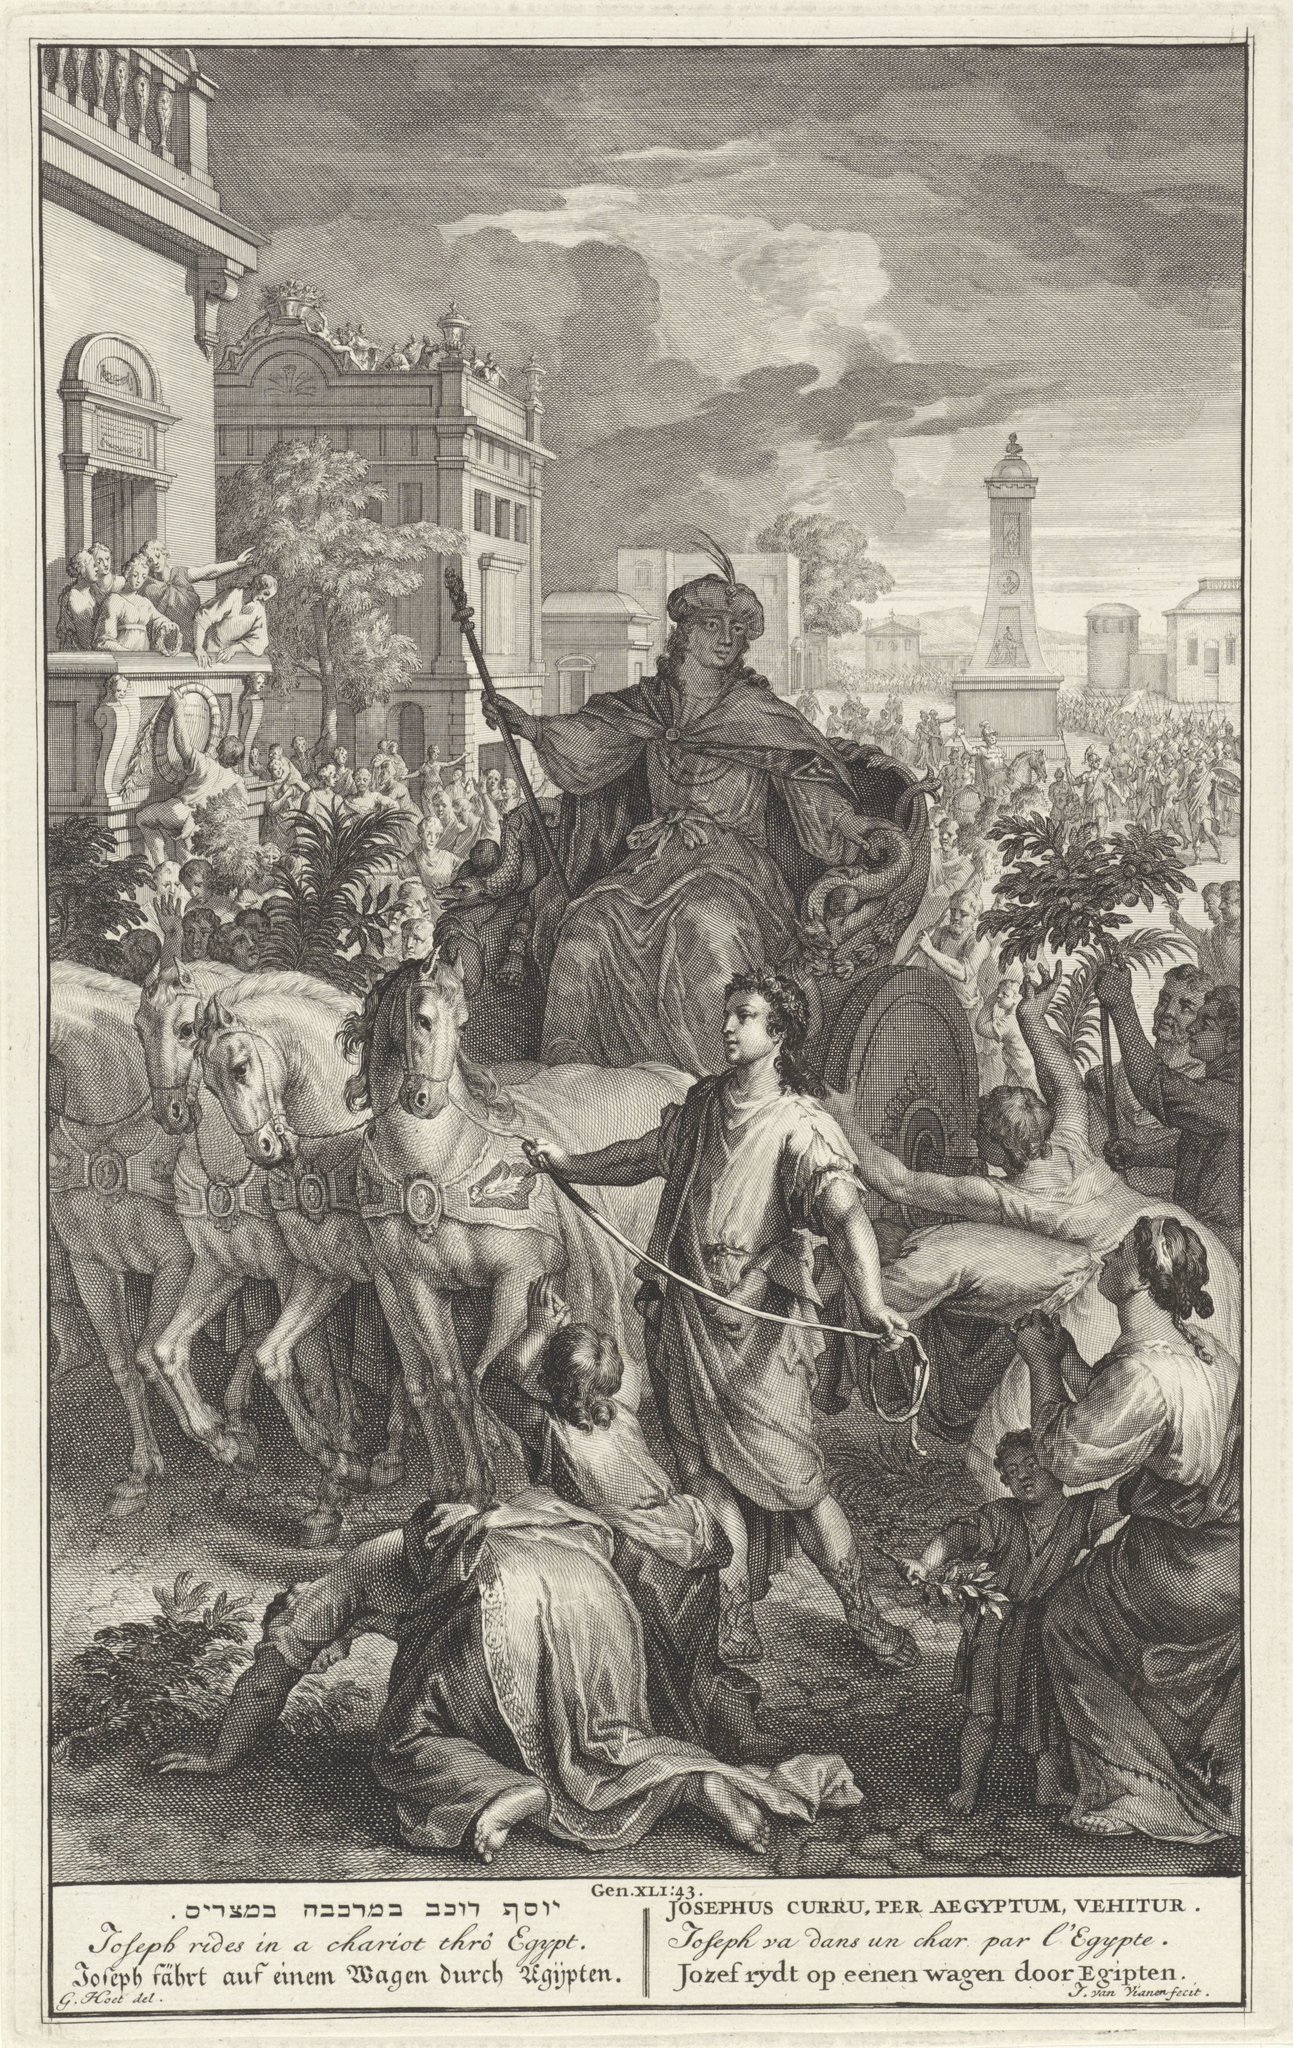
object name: book illustration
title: Jozef rijdt op een wagen door Egypte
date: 1705-1720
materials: paper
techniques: engraving, etching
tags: triumph of joseph: dressed in a royal attire he rides in one of pharaoh's chariots, preceded by a herald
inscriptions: collector's mark: Lugt 2228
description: Prent oorspronkelijk bedoeld voor: Figures de la Bible. Amsterdam: Bernard Picart, 1720. Prent ook gebruikt in: Taferelen der voornaamste geschiedenissen van het Oude en Nieuwe Testament (...) door de vermaarde kunstenaars Hoet, Houbraken, en Picart getekent (...) en met beschrijvingen uitgebreid. Den Haag: Pieter de Hondt, 1728.